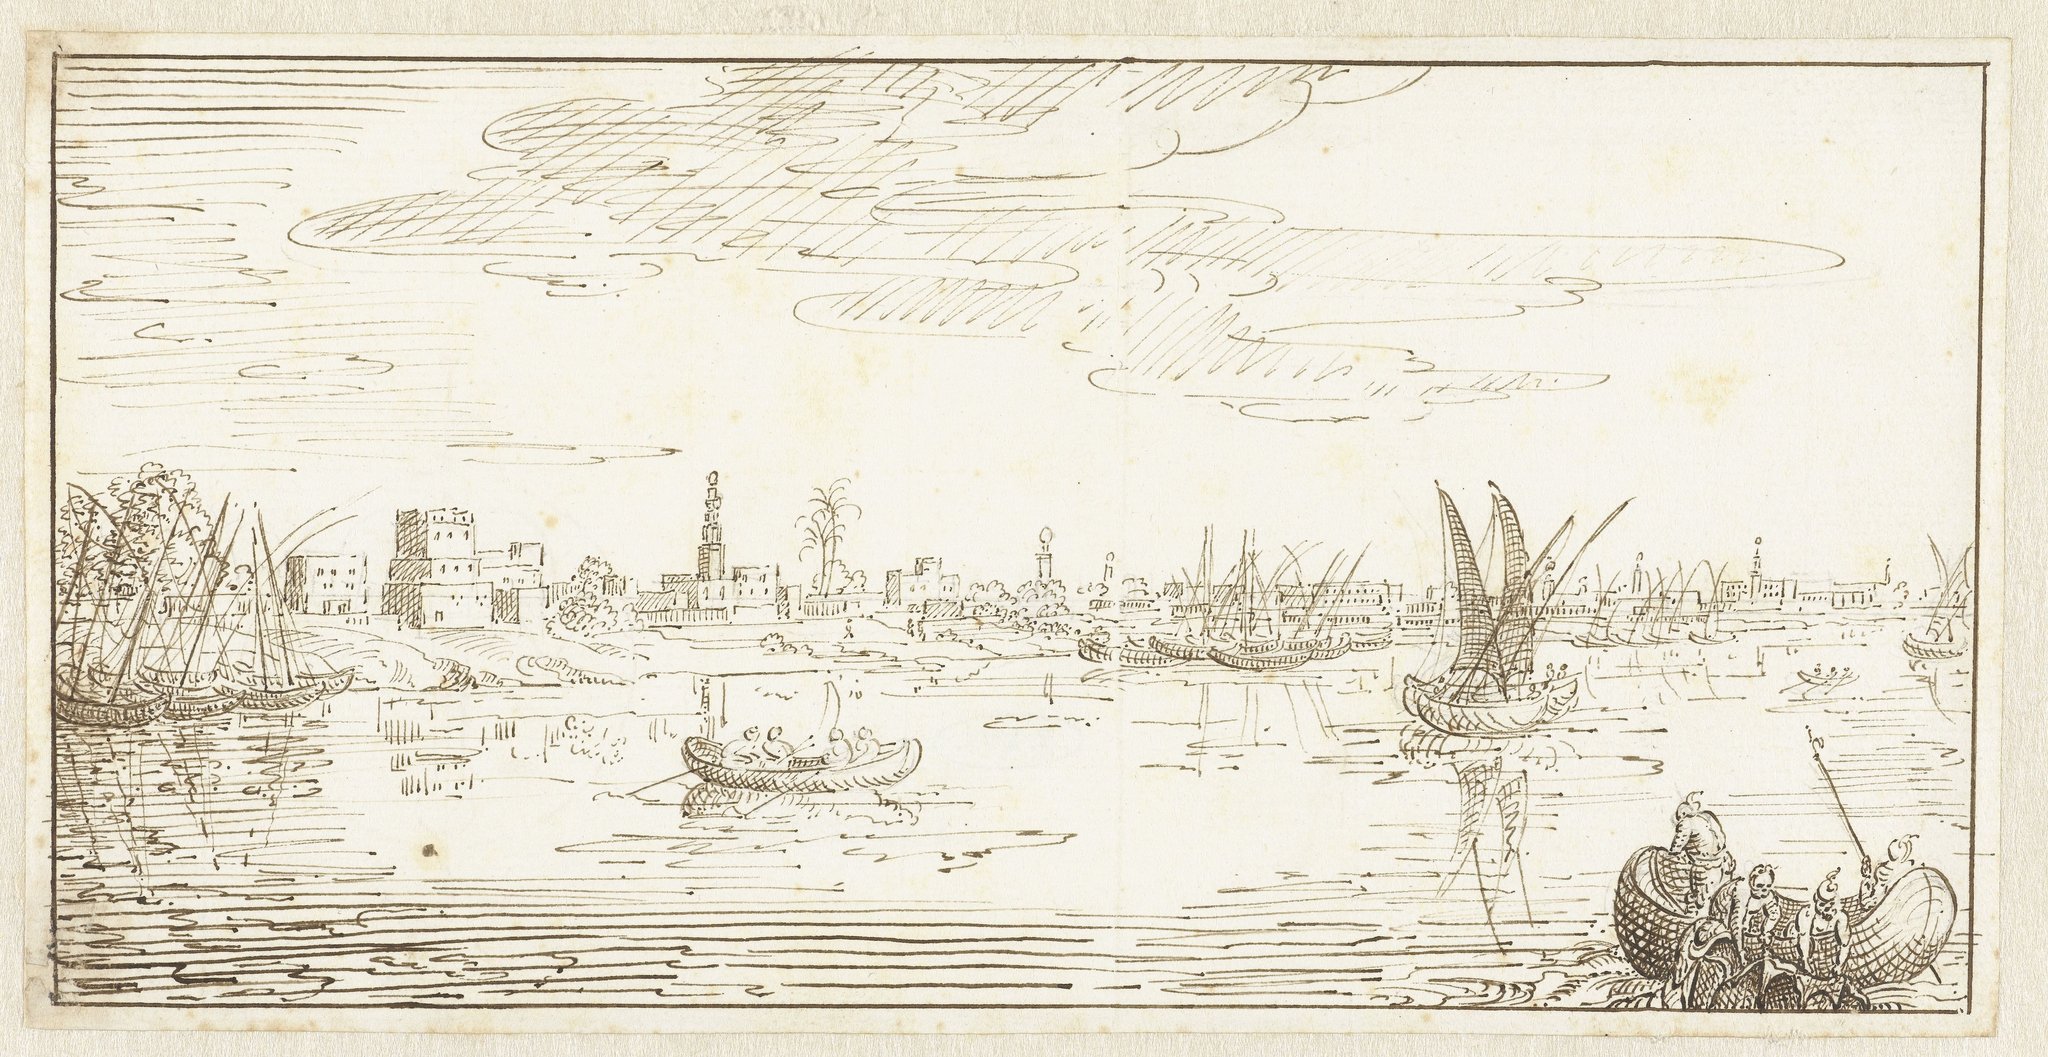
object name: drawing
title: Gezichten rond de Middellandse Zee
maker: johan teyler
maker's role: draughtsman, print maker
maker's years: 1648-1712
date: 1679-1683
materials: ink, paper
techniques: pen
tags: river, sea and coastal fishery